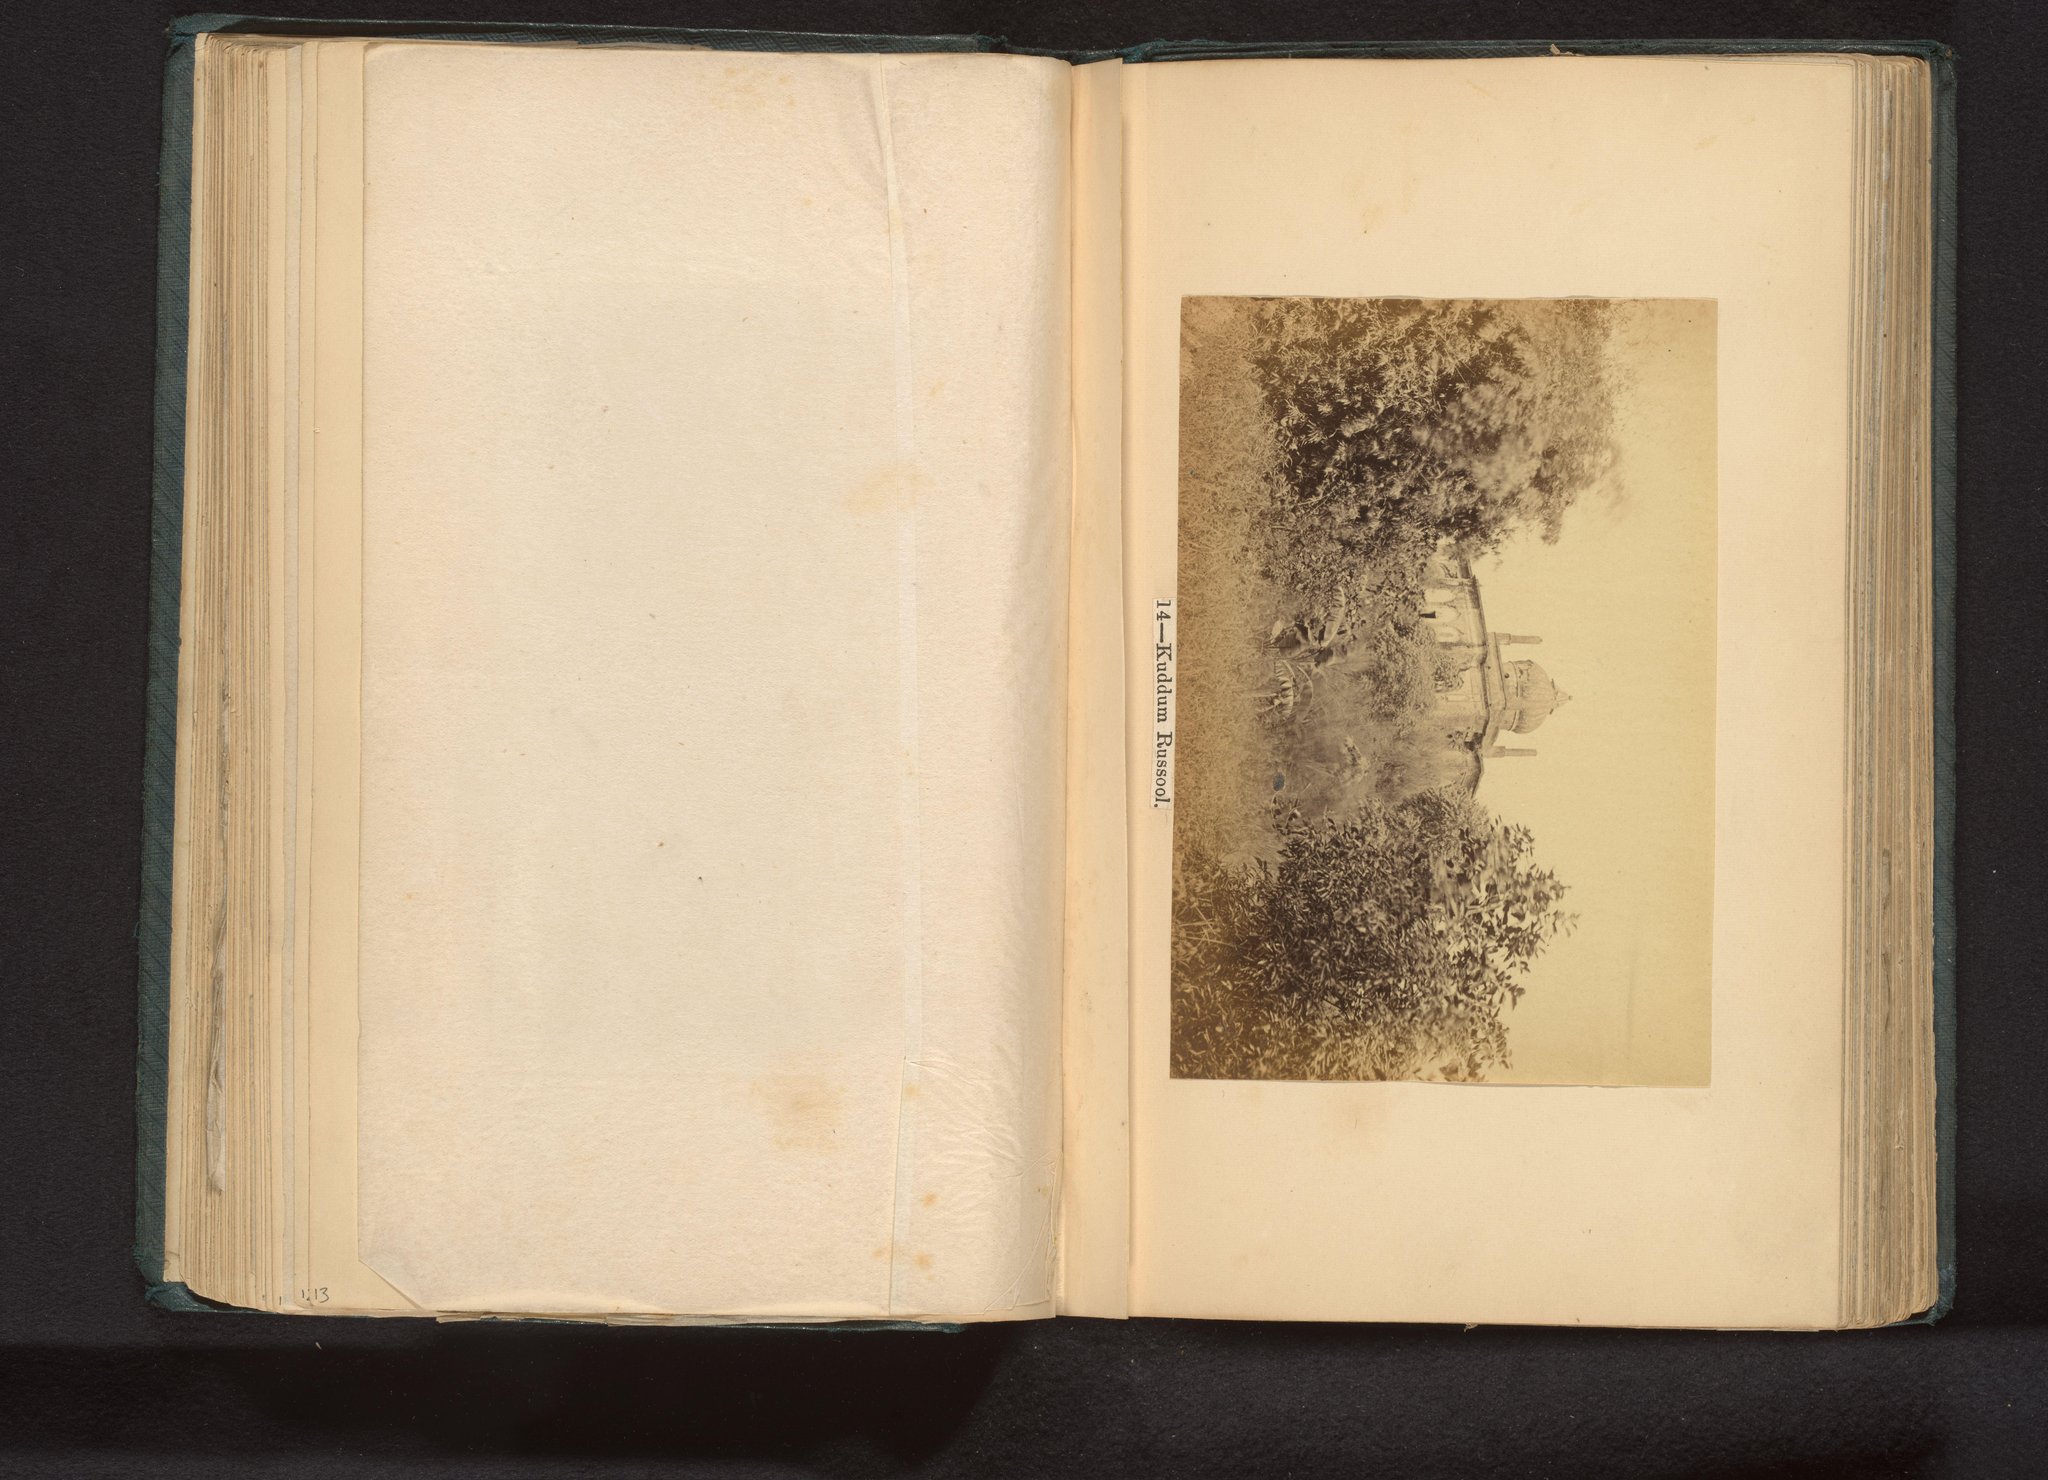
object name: photograph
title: Gezicht op de Qadam Rasul in Lucknow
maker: darogha ubbas alli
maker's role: fotograaf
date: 1864-1874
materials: photographic support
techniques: albumen print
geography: lucknow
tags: temple, shrine ~ islam, mohammedanism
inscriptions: number: ‘14’